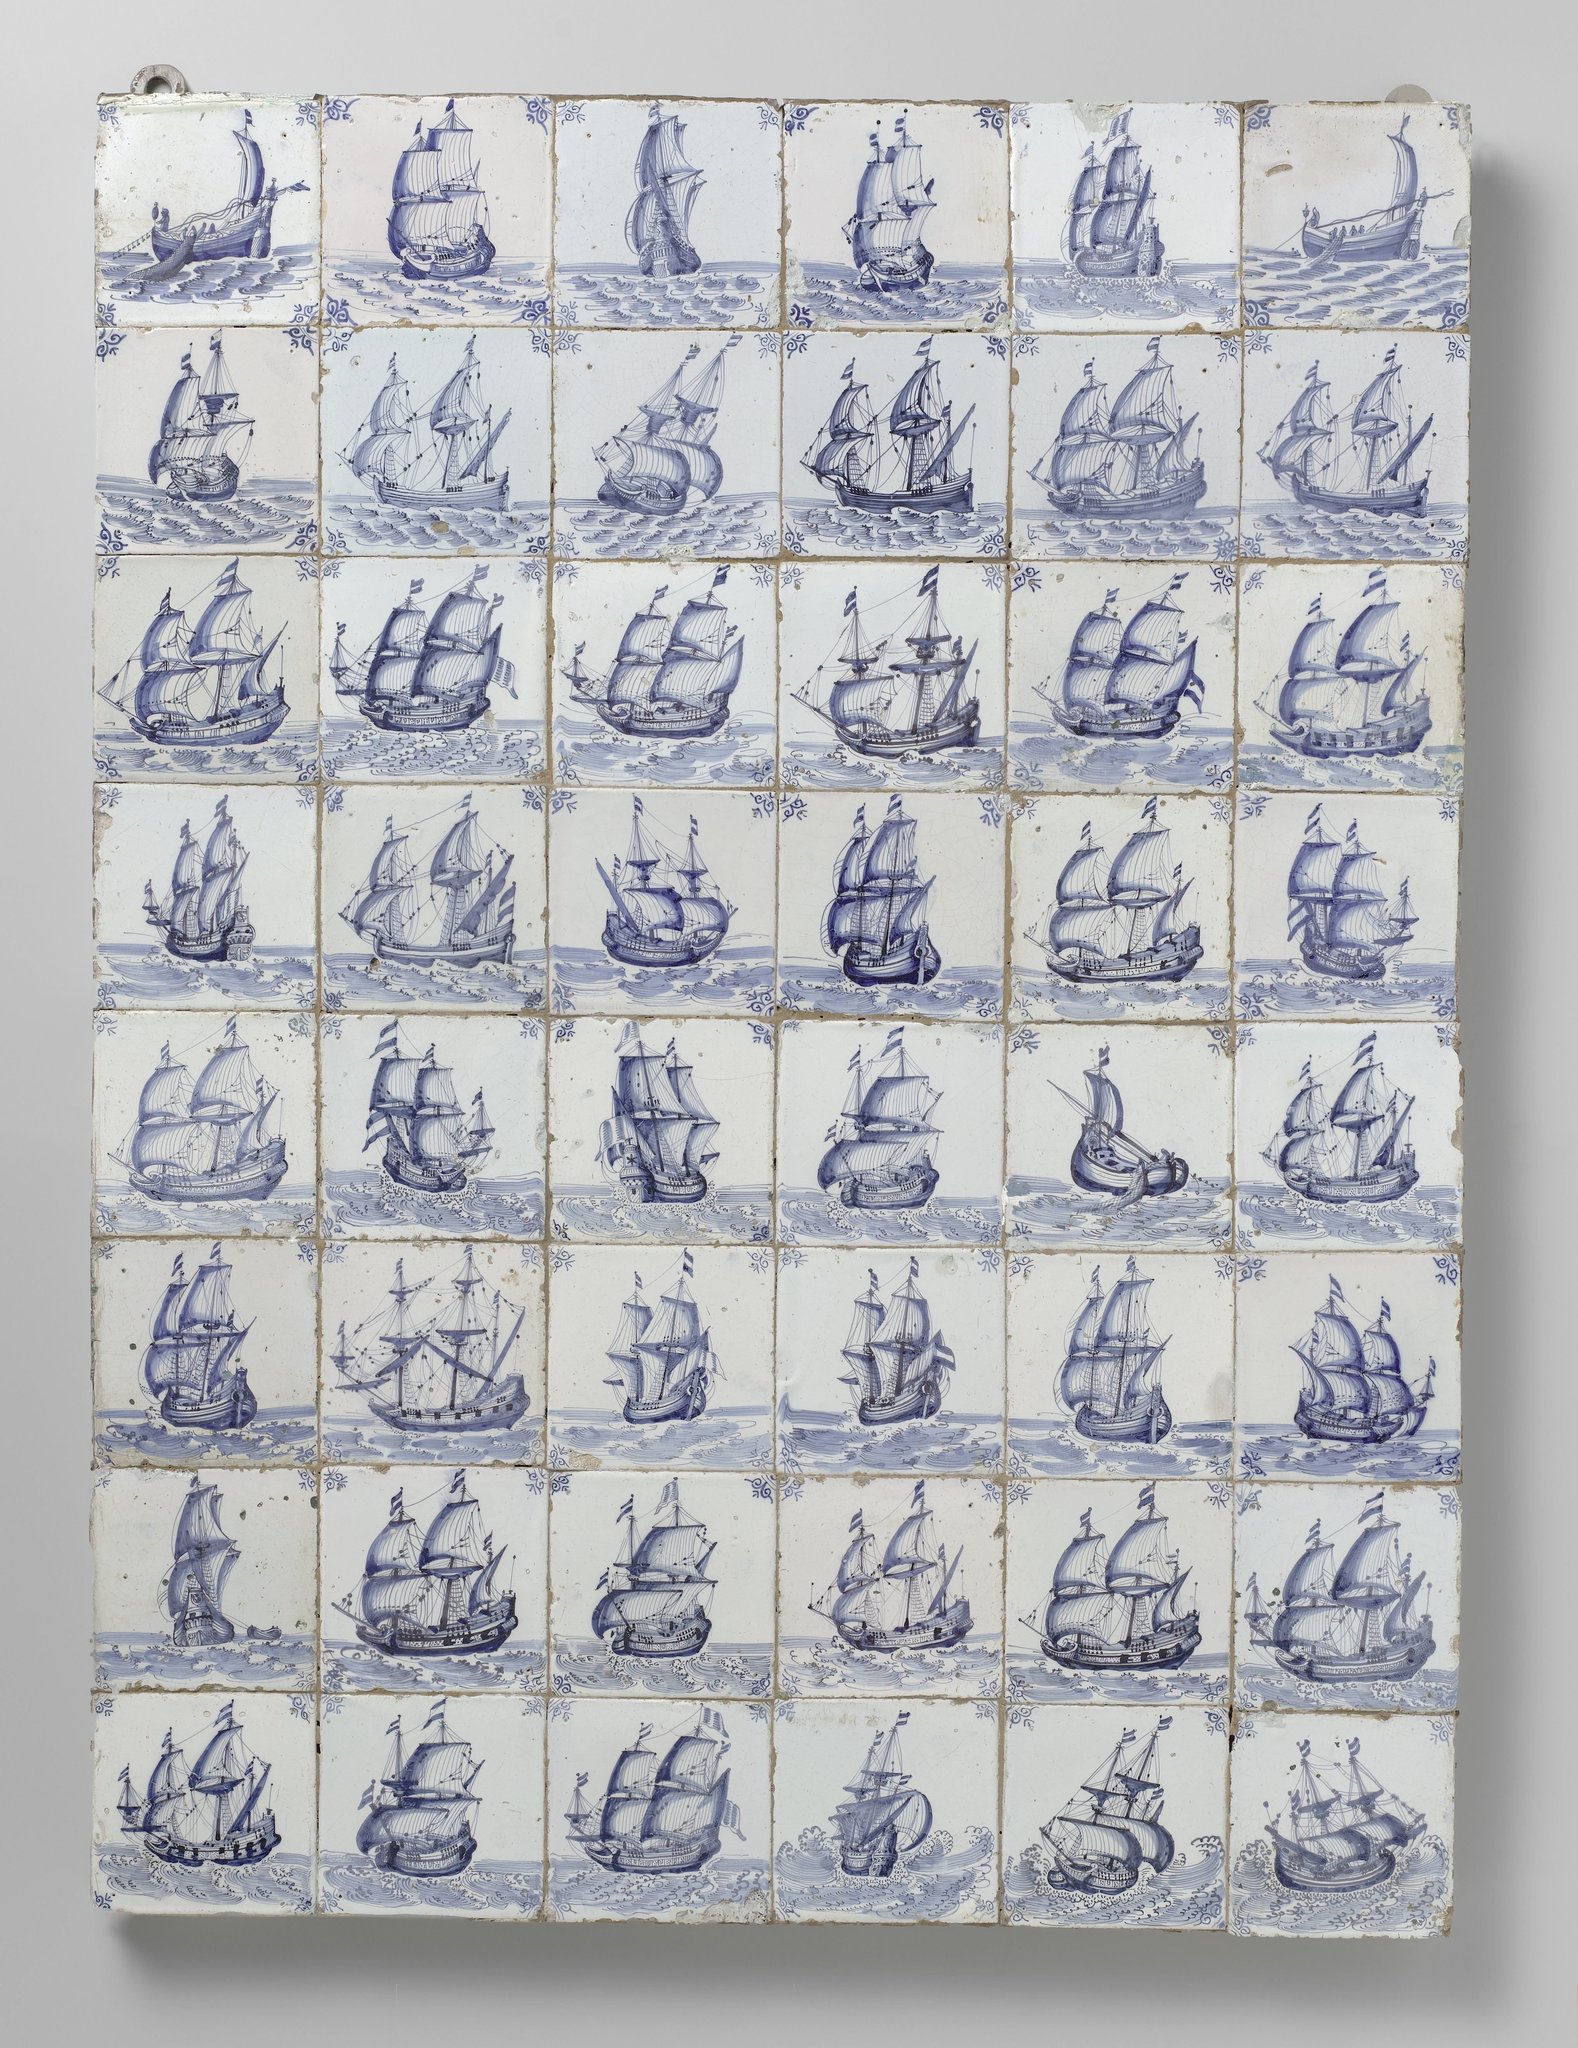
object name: tile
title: Veld van achtenveertig tegels met schepen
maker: Anonymous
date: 1650-1680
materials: earthenware, glaze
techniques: maiolica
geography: netherlands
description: Veld van achtenveertig tegels (8 x 6) elk met een blauw en paars geschilderd schip. In de hoeken, een ossenkop.